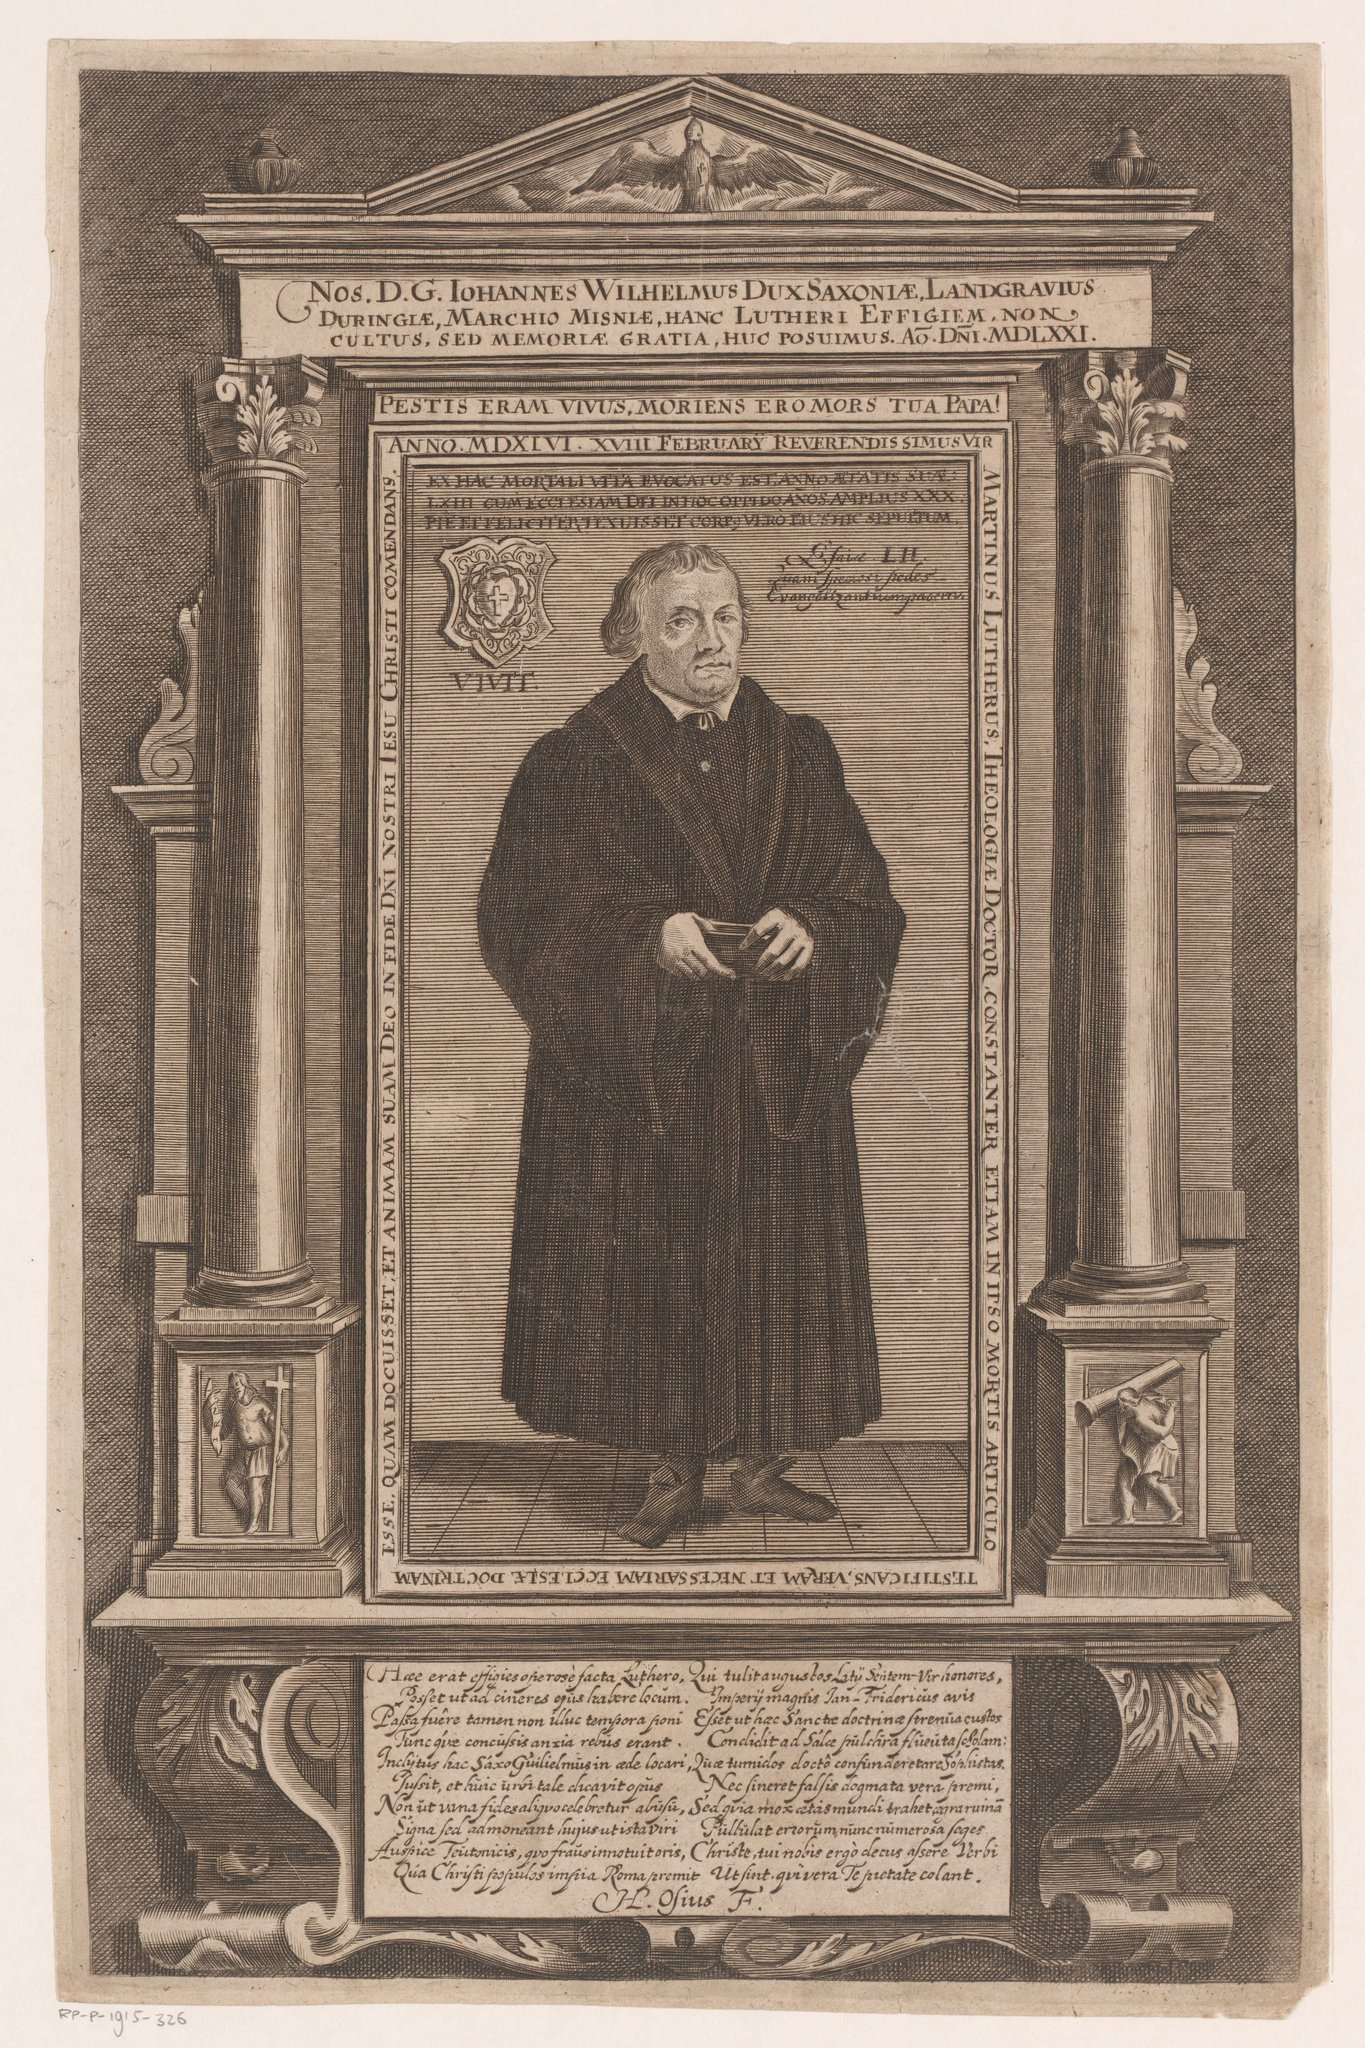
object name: print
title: Epitaaf van Martin Luther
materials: paper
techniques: engraving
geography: germany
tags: priest, martin luther, historical persons, epitaph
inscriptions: collector's mark: Lugt 2228